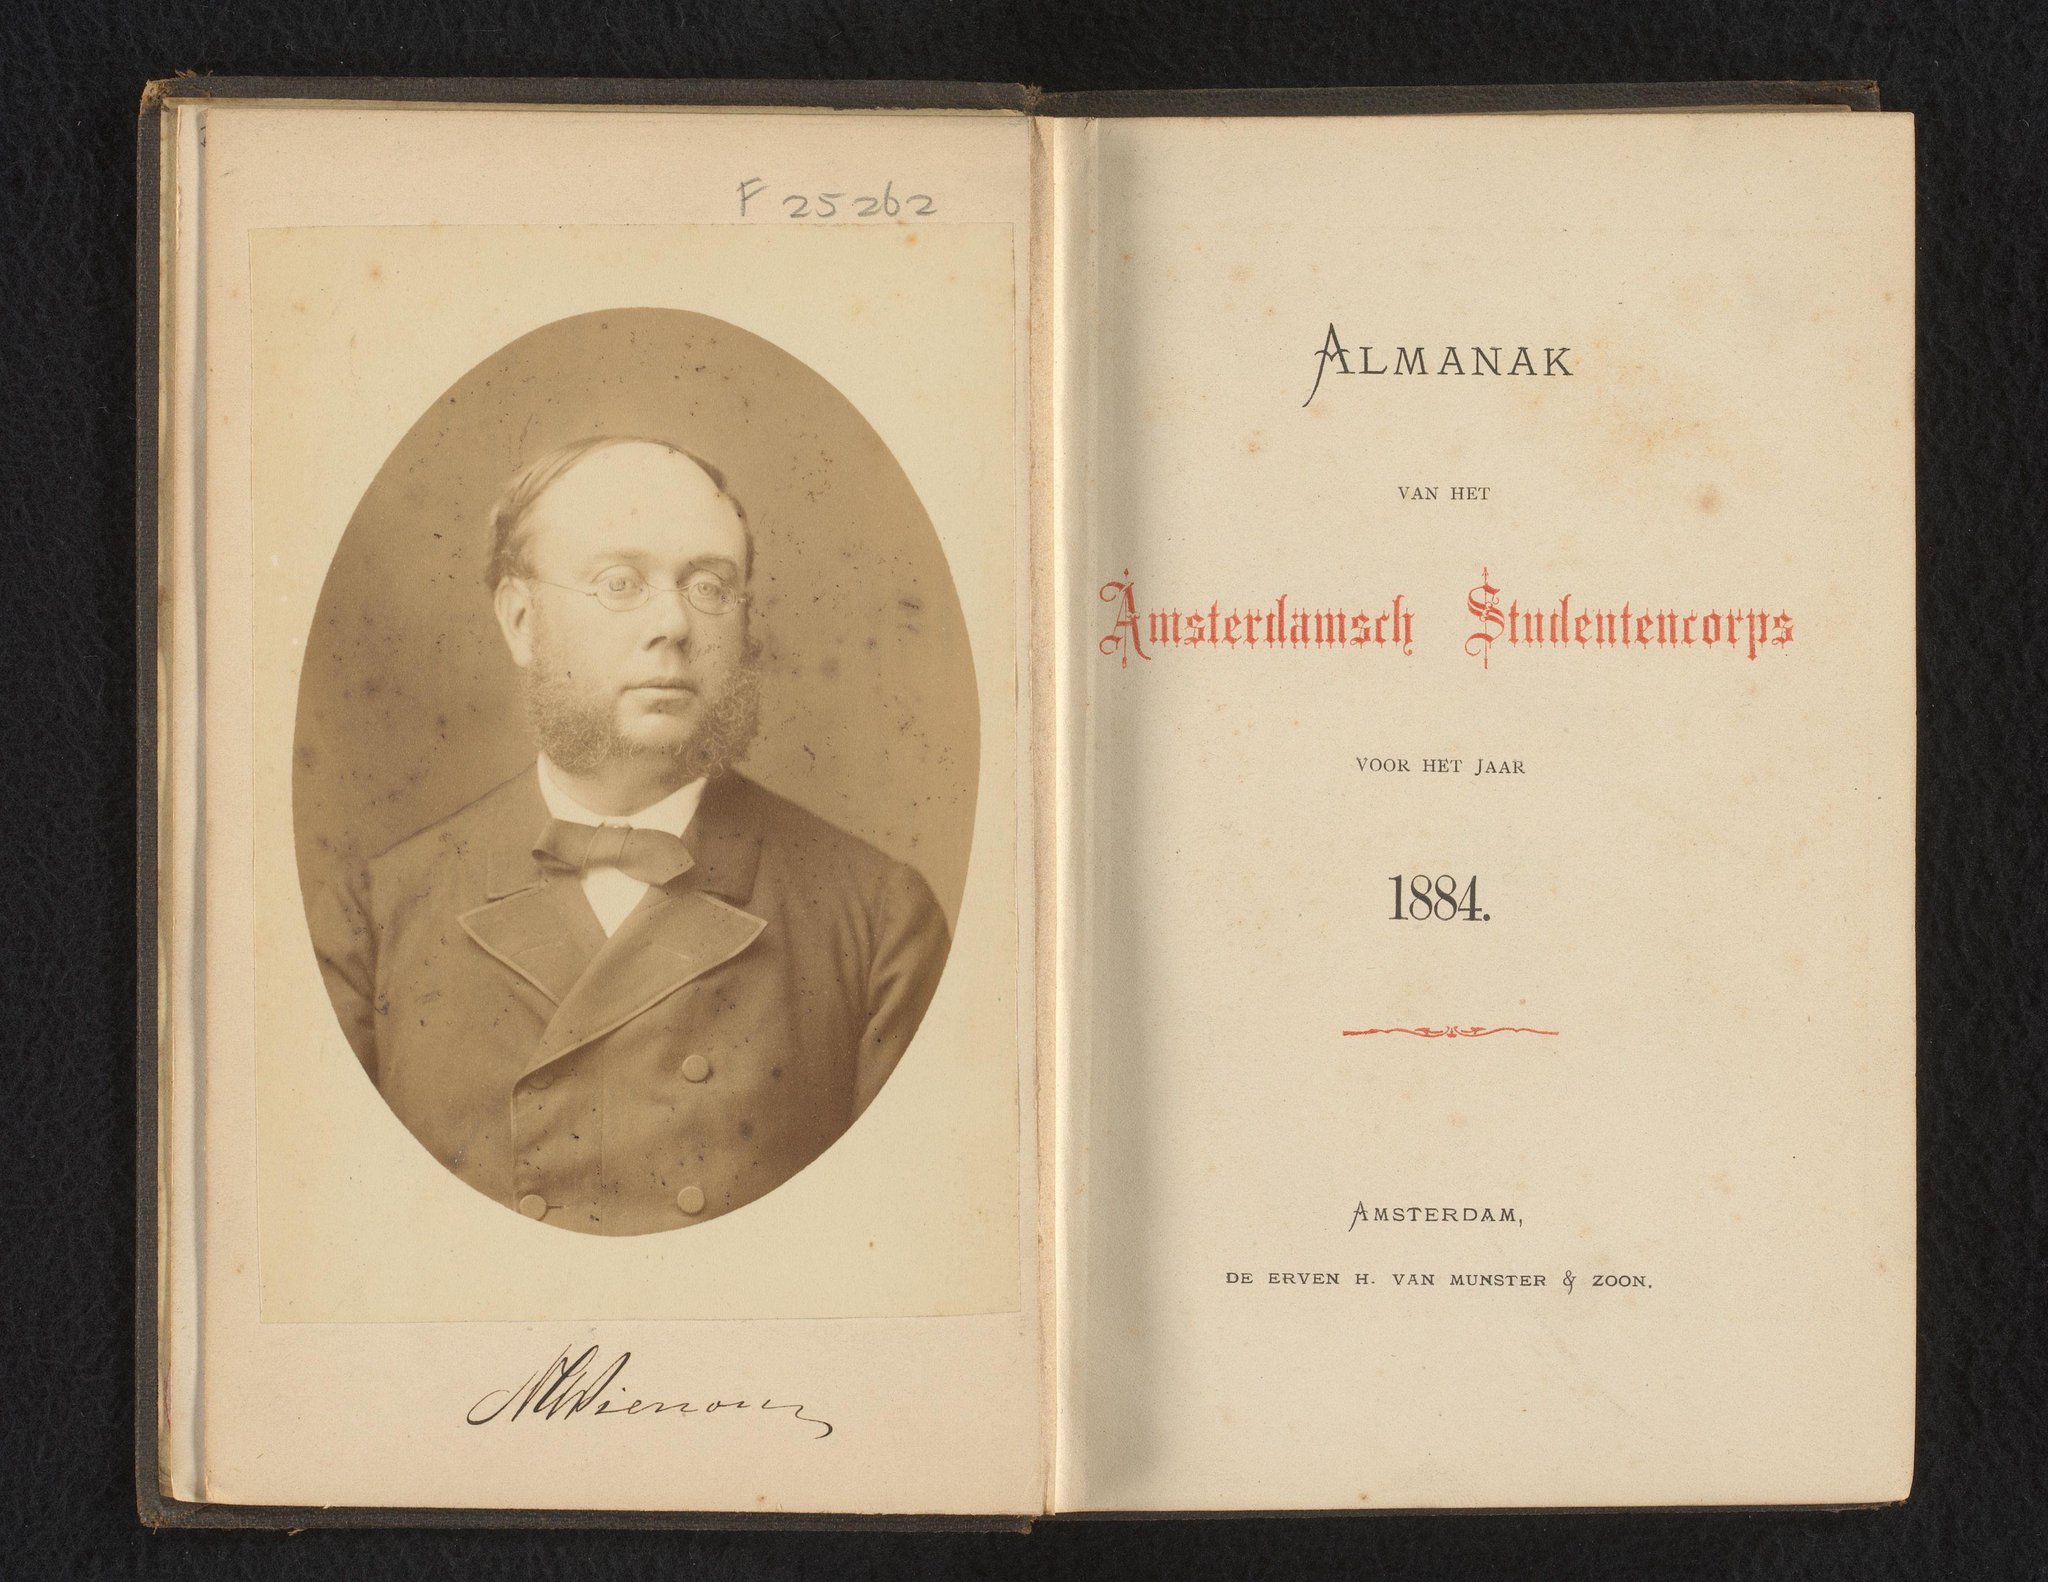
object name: photograph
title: Portret van N.G. Pierson, hoogleraar rechtsgeleerdheid aan de Universiteit van Amsterdam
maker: Anonymous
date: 1883-1884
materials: paper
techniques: albumen print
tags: amsterdam, nicolaas gerard pierson, historical persons, professor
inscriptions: signature: ‘NG Pierson’